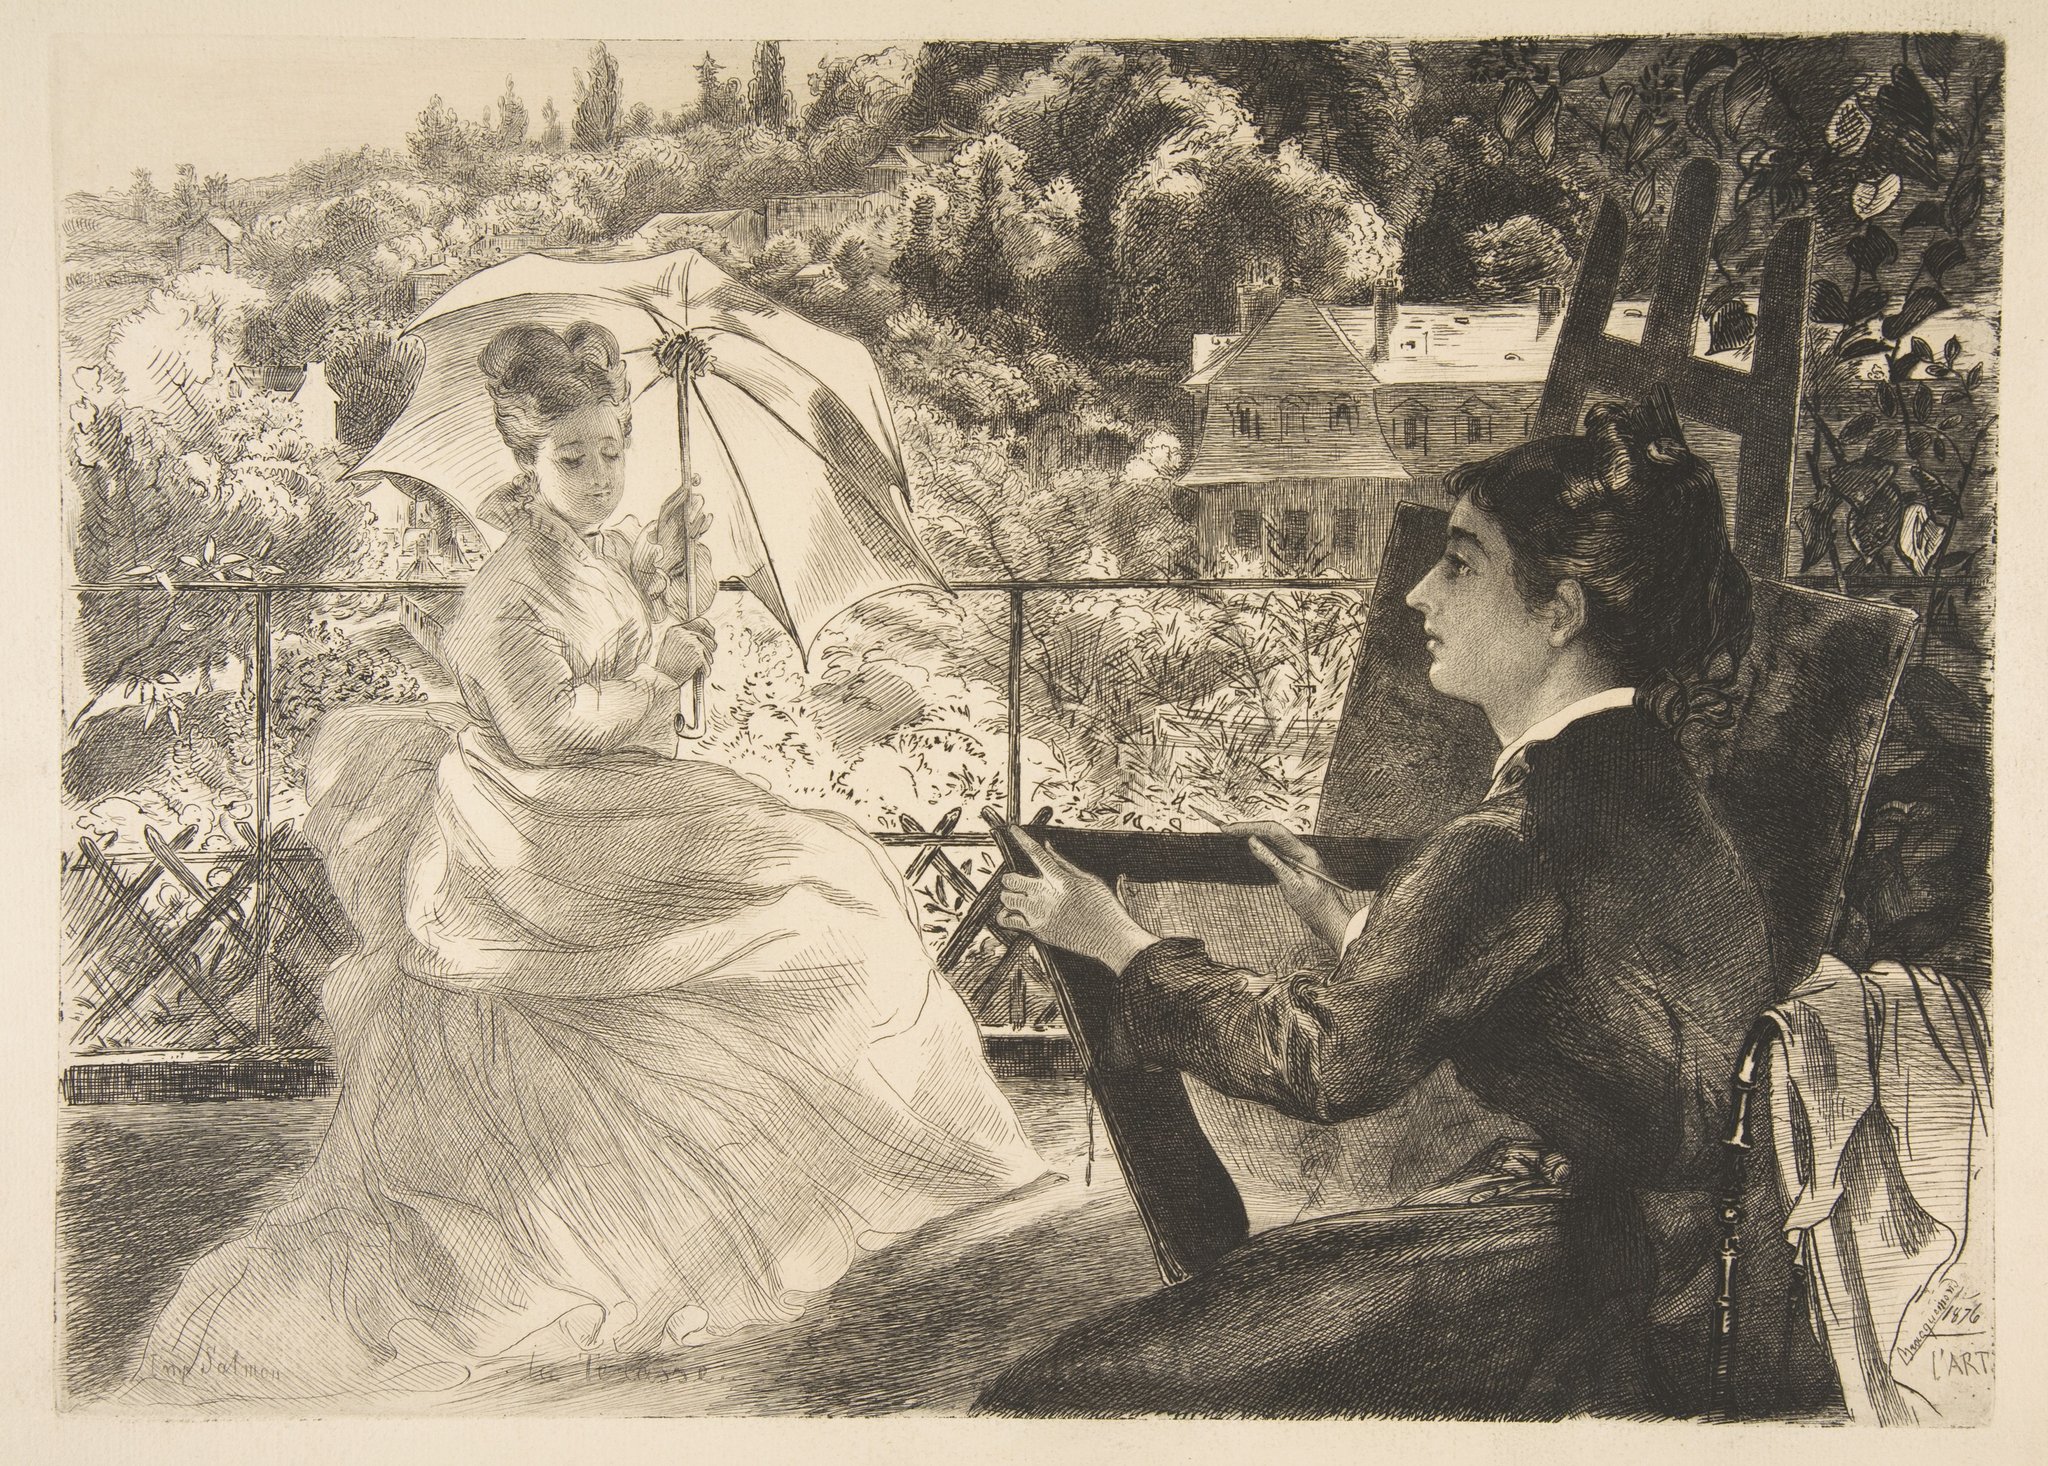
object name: print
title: La Terrasse de la Villa Brancas, from "L'Art"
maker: félix bracquemond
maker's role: artist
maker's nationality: french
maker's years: 1833-1914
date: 1876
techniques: drypoint, etching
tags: painting,women,parasols